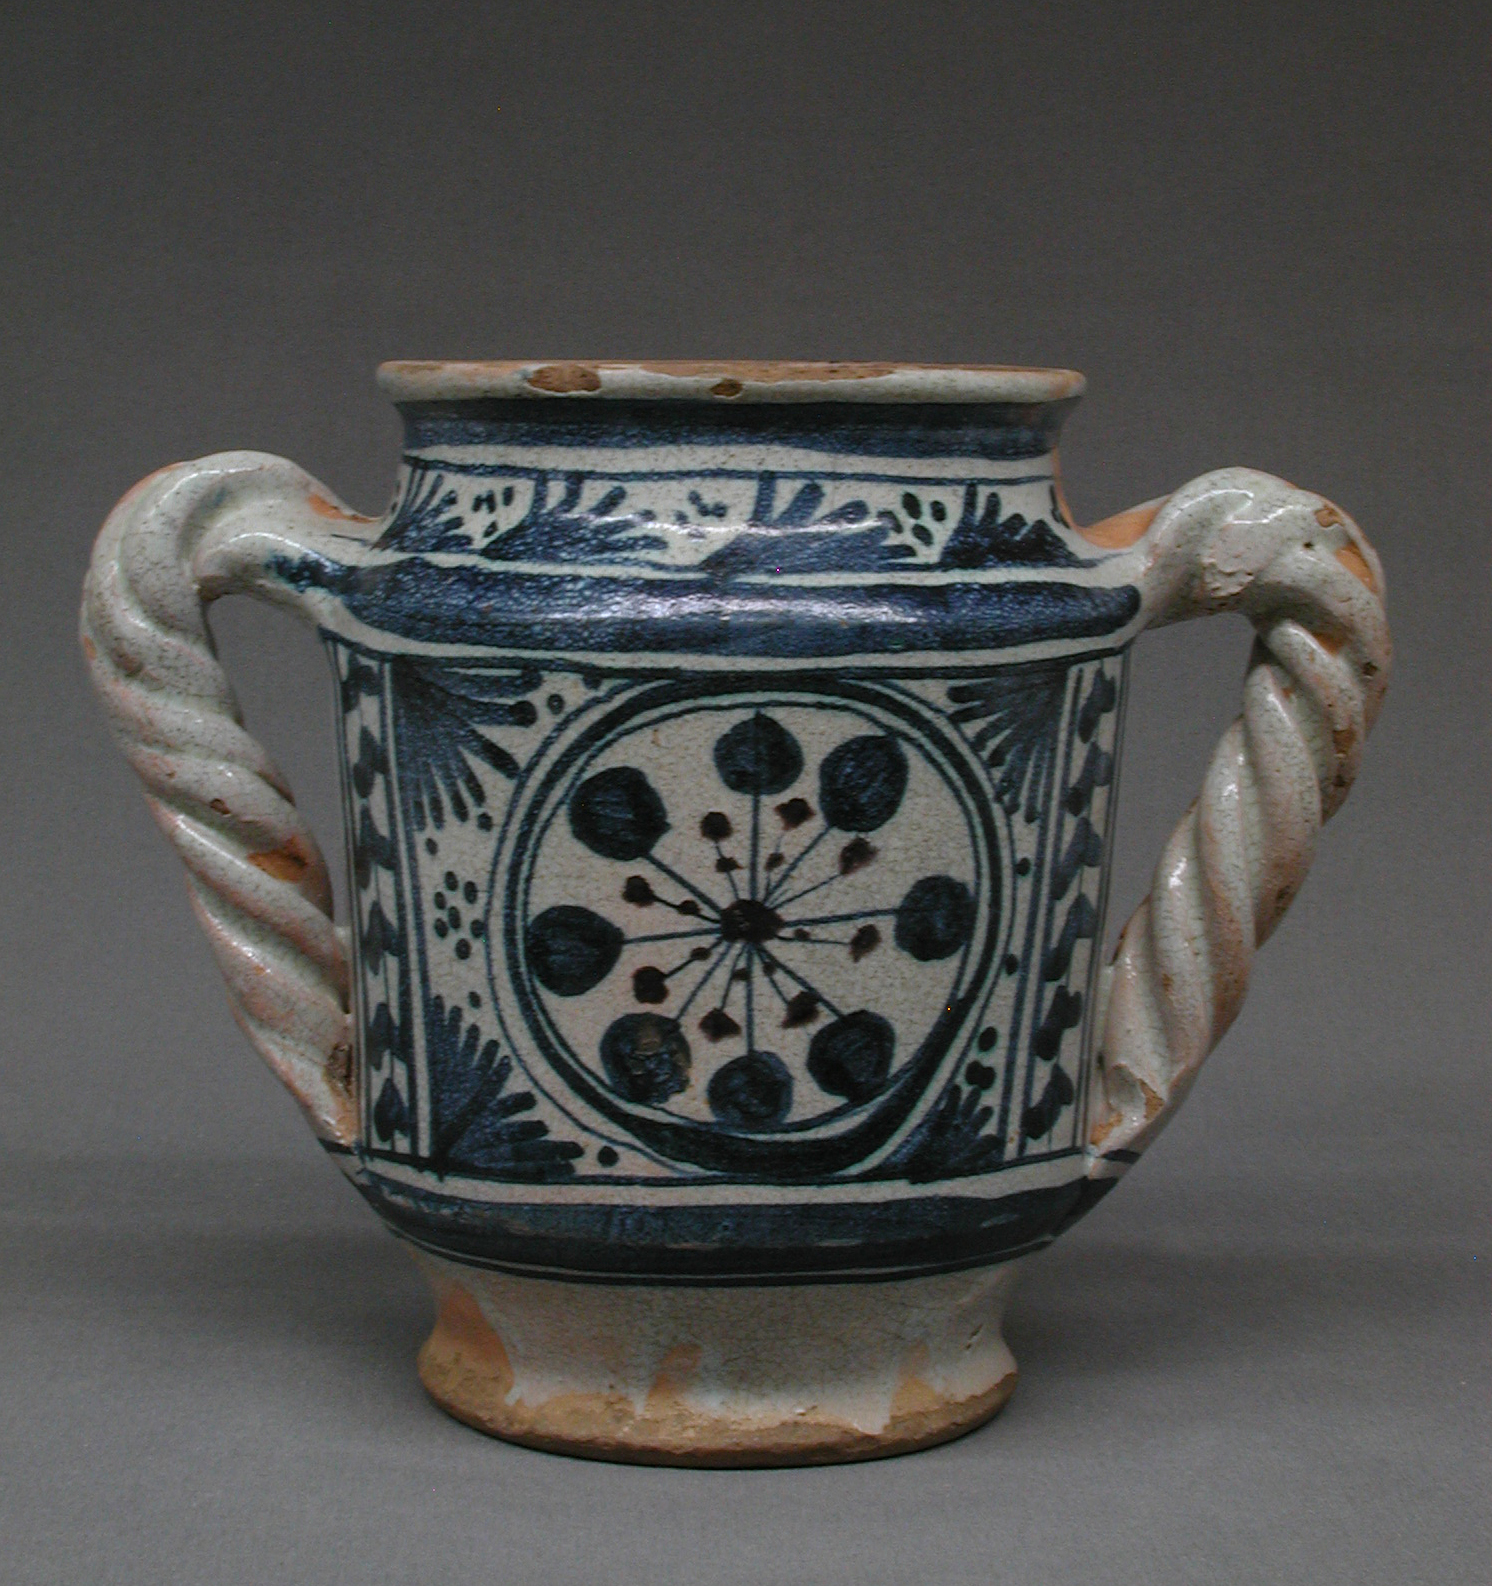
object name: vase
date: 1467-1500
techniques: maiolica, glazing